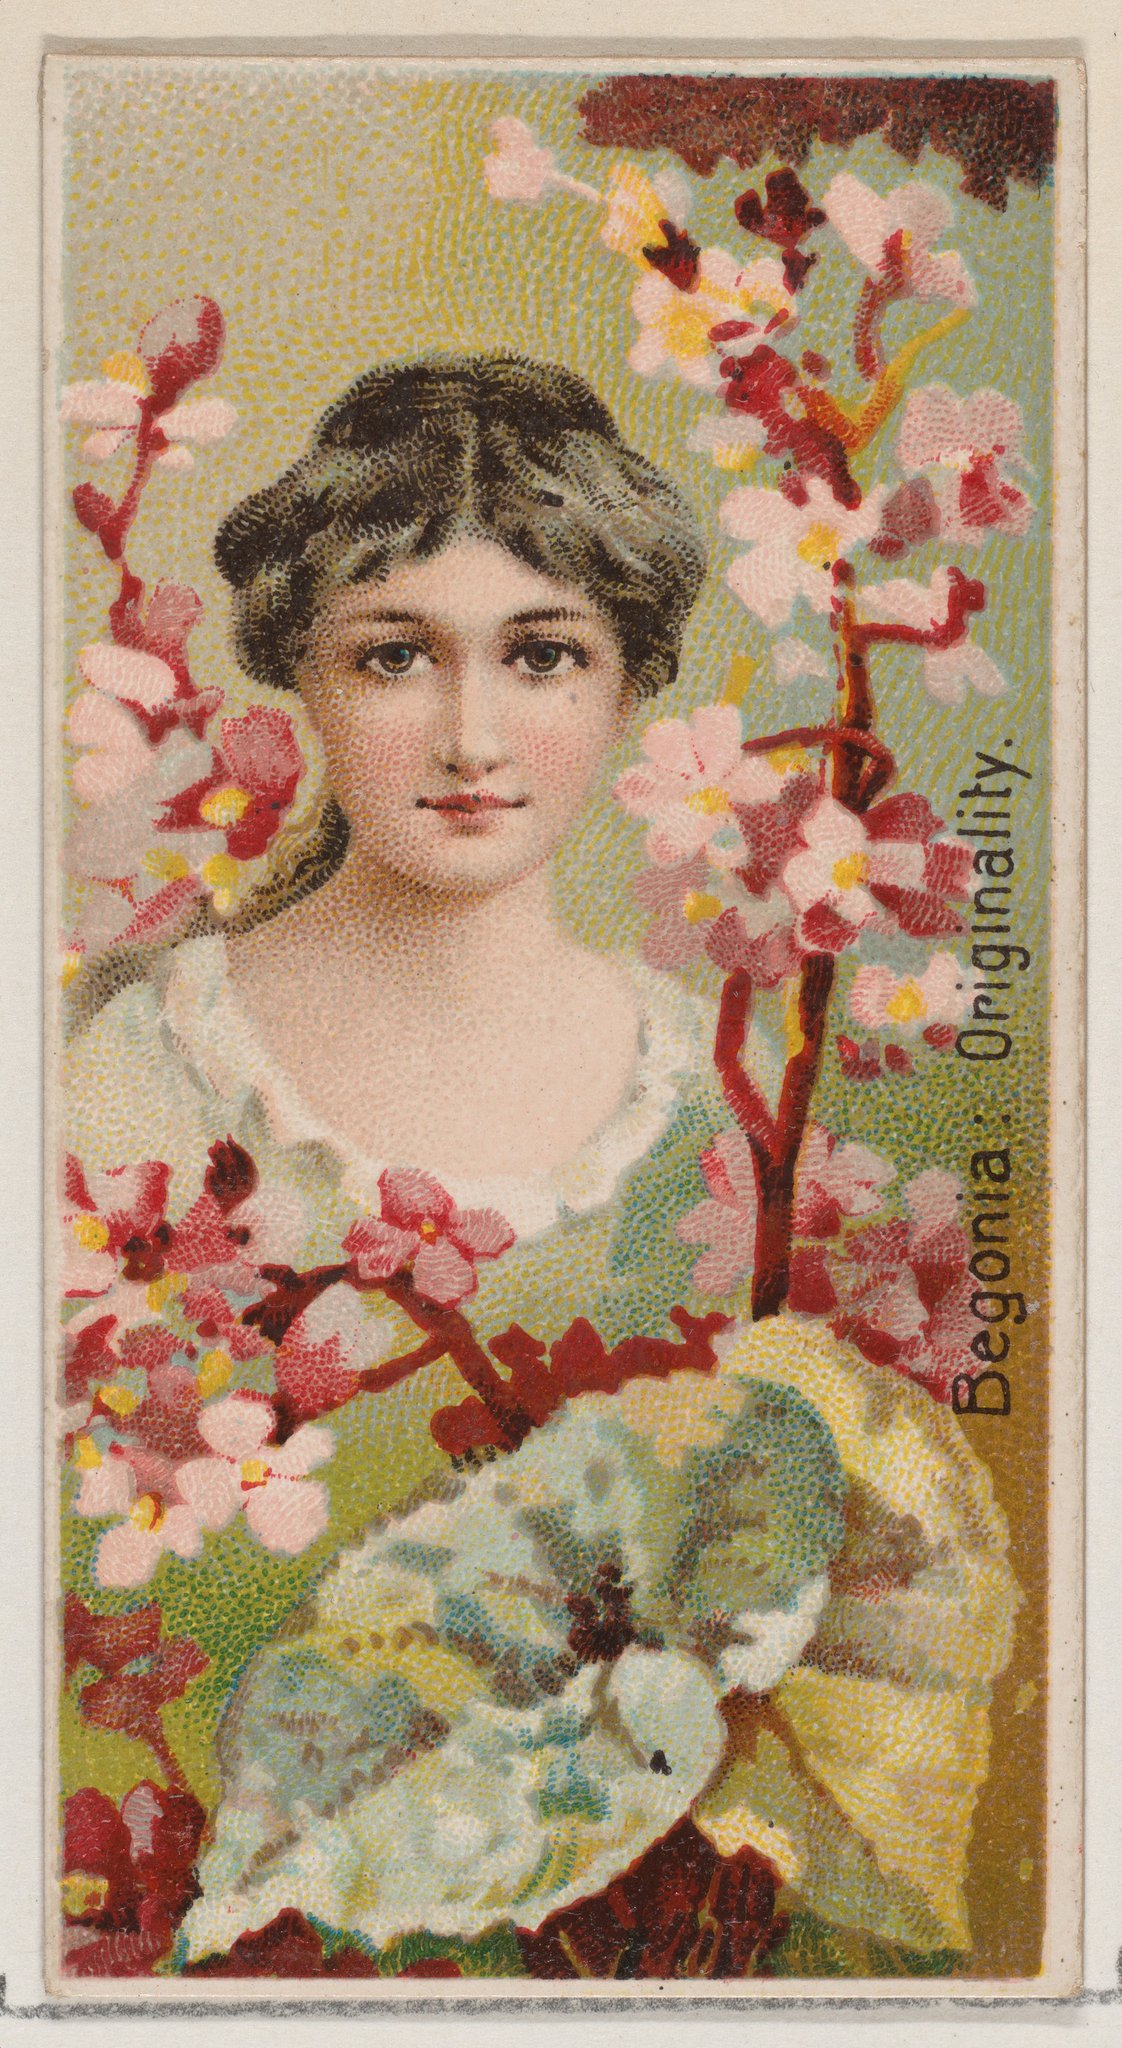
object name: print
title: Begonia: Originality, from the series Floral Beauties and Language of Flowers (N75) for Duke brand cigarettes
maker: american tobacco company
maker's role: publisher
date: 1892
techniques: color lithograph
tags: women,flowers